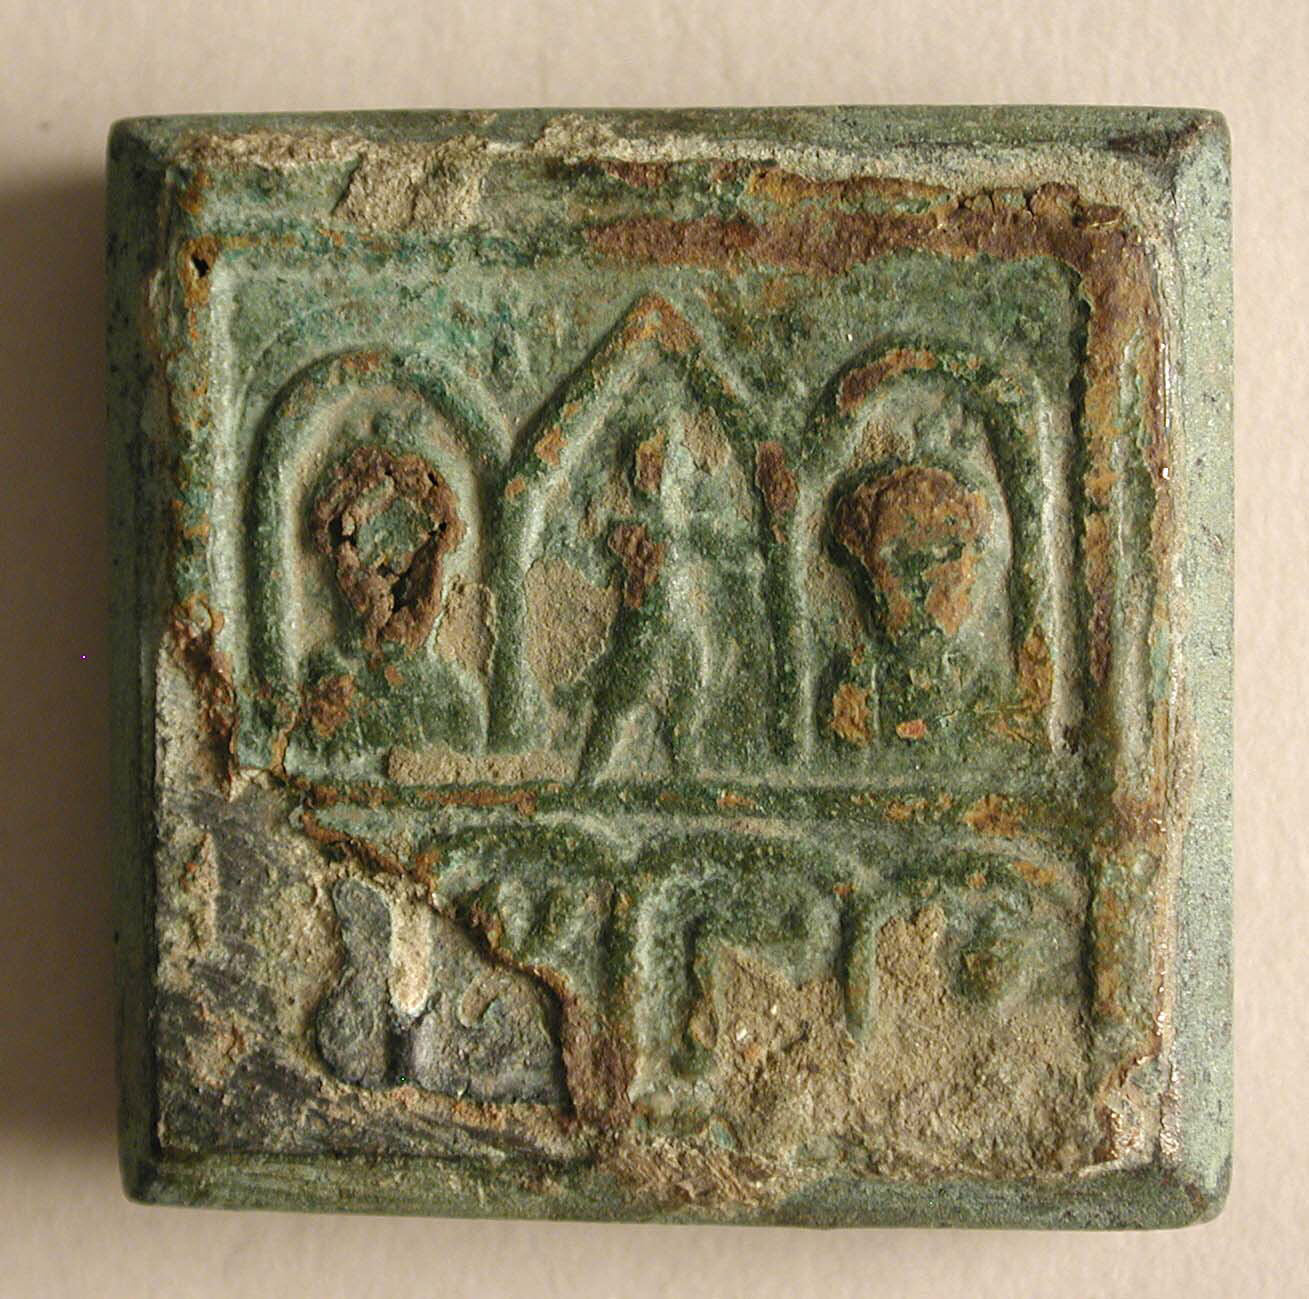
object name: weight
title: Copper-Alloy Balance Weight with Figures in an Architectural Setting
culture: byzantine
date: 401-600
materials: copper alloy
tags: portraits